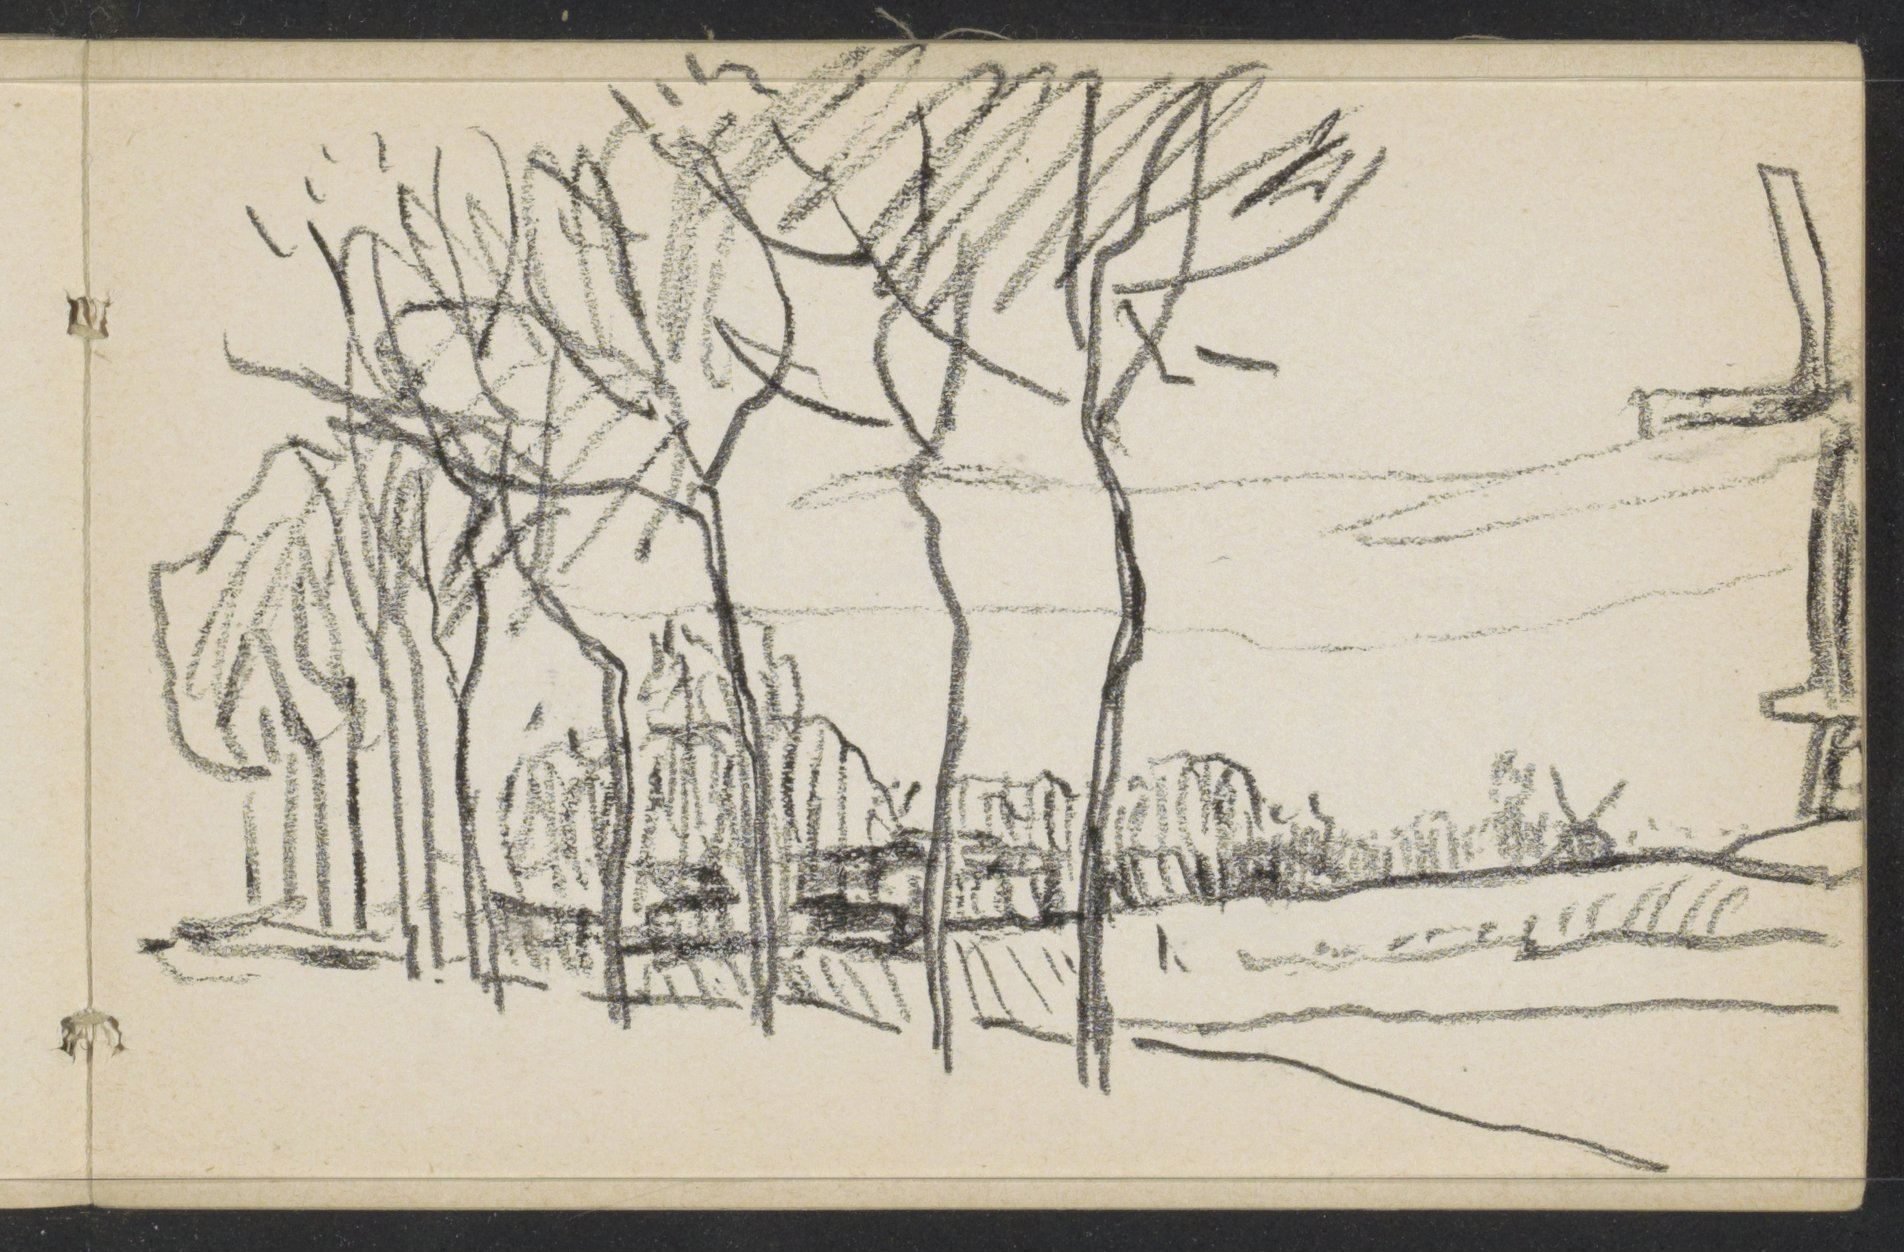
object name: sketchbook leaf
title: Bomenlaan in een landschap met molens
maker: alexander shilling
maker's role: draughtsman, print maker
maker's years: 1859-1937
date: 1910-1923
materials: chalk, paper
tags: trees, windmill in landscape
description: Blad 20 recto uit een schetsboek met 26 bladen.